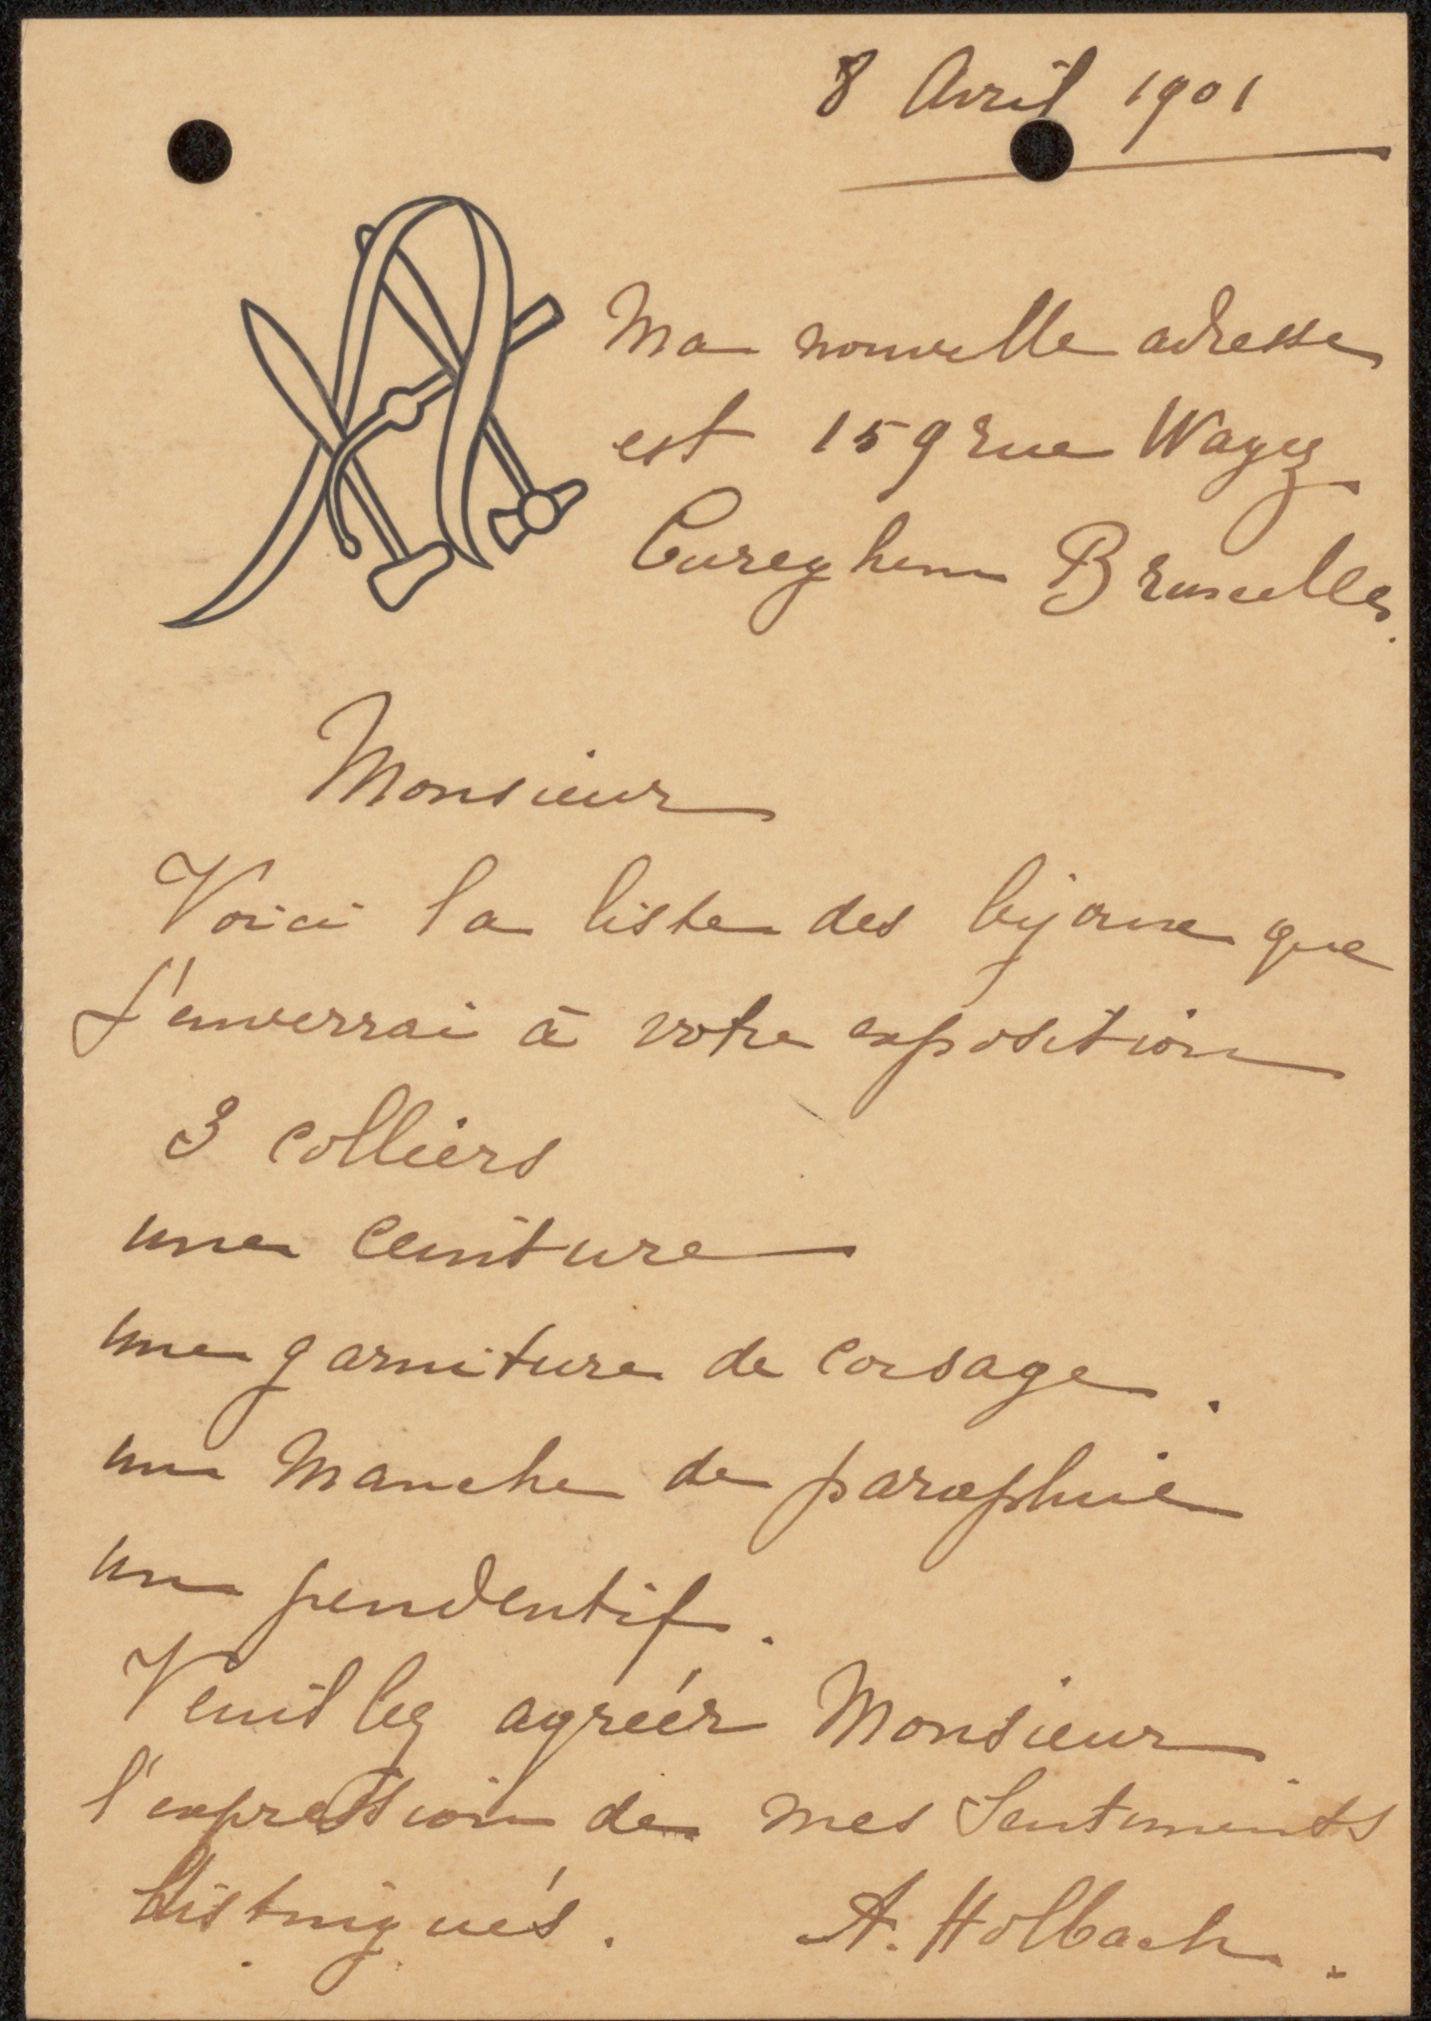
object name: letter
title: Brief aan Philip Zilcken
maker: alice holbach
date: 1901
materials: ink, paper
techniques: pen, printing, writing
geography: brussels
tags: painter, draughtsman, philip zilcken, temporary exhibition, 'salon'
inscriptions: collector's mark: ‘RPK’, monogram: ‘AH’